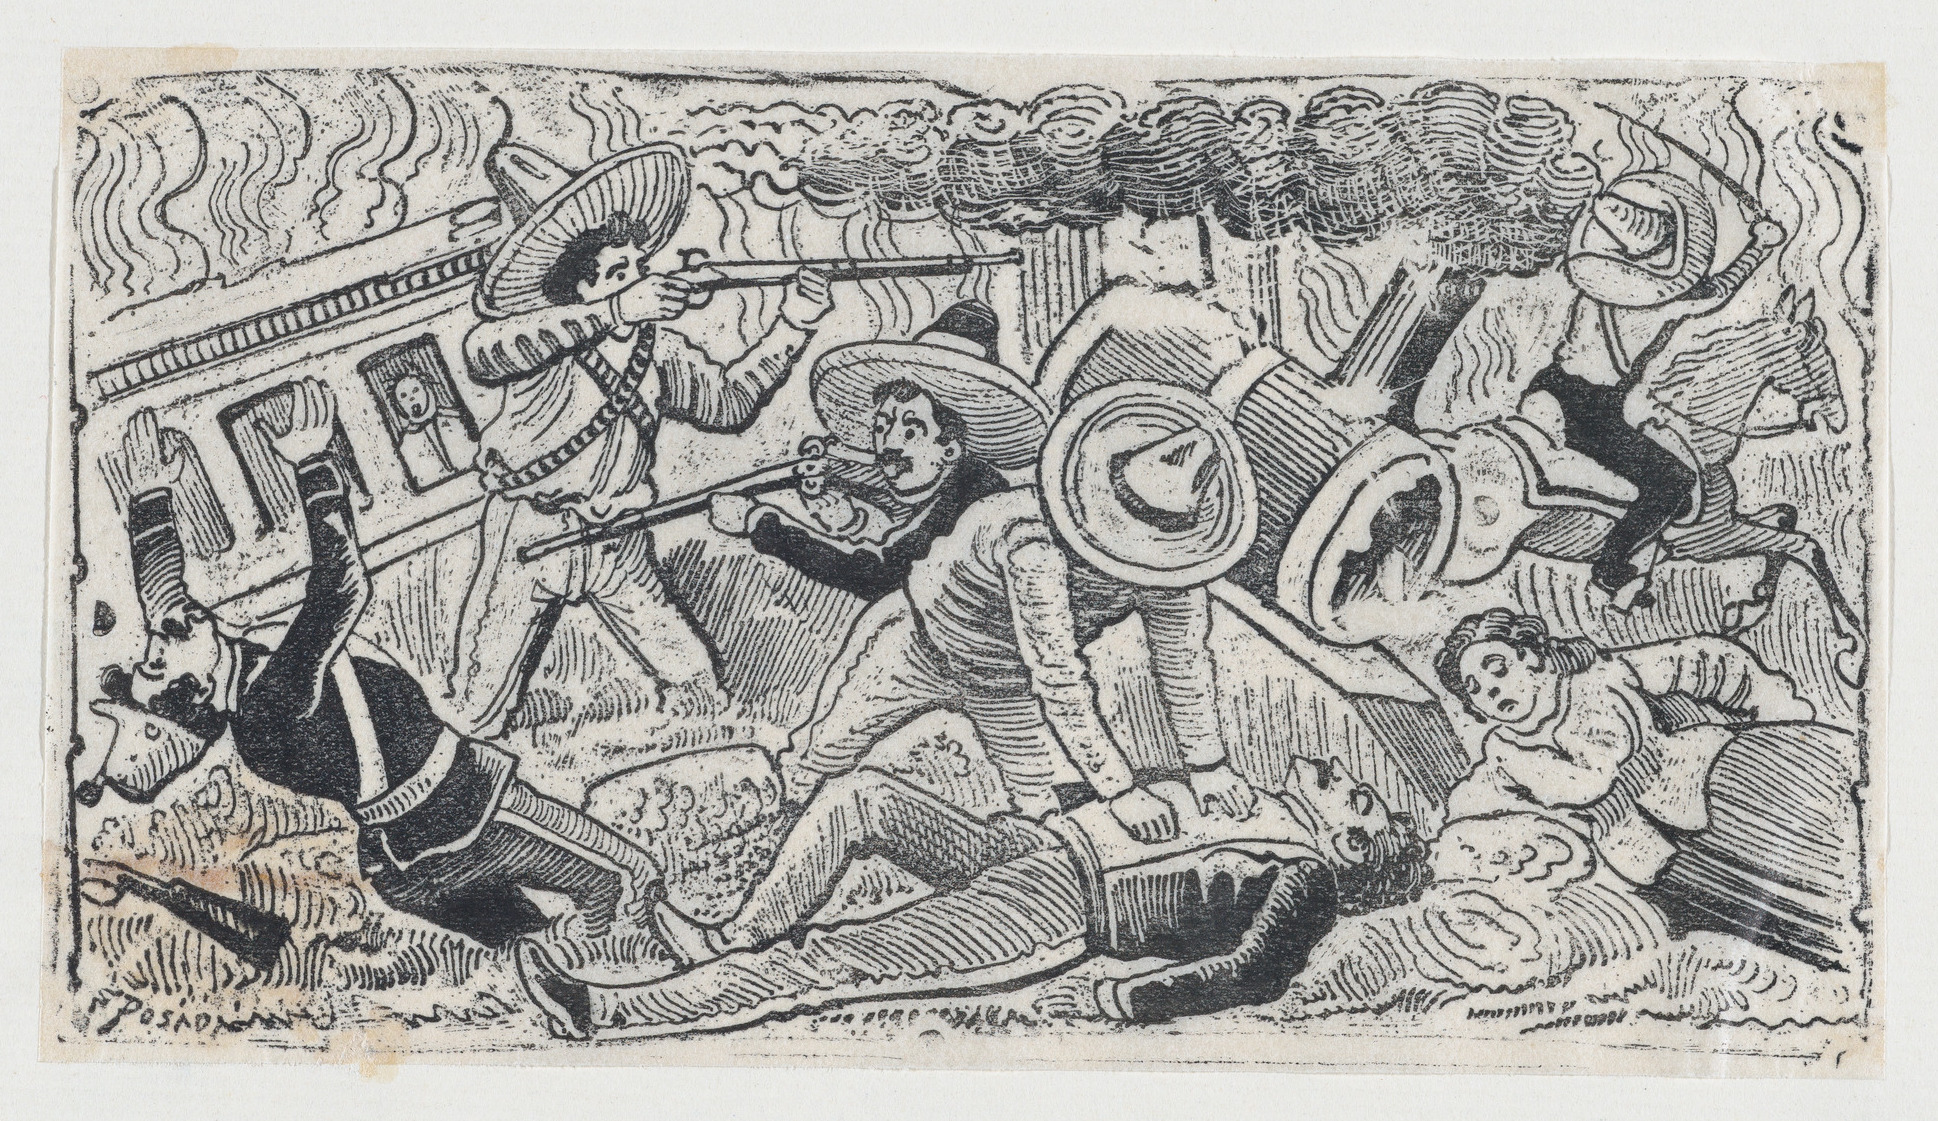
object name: print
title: Emiliano Zapata's supporters attacking a train, scene from the Mexican Revolution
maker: josé guadalupe posada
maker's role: artist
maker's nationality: mexican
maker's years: 1852-1913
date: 1911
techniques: lithography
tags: firearms,men,women,trains